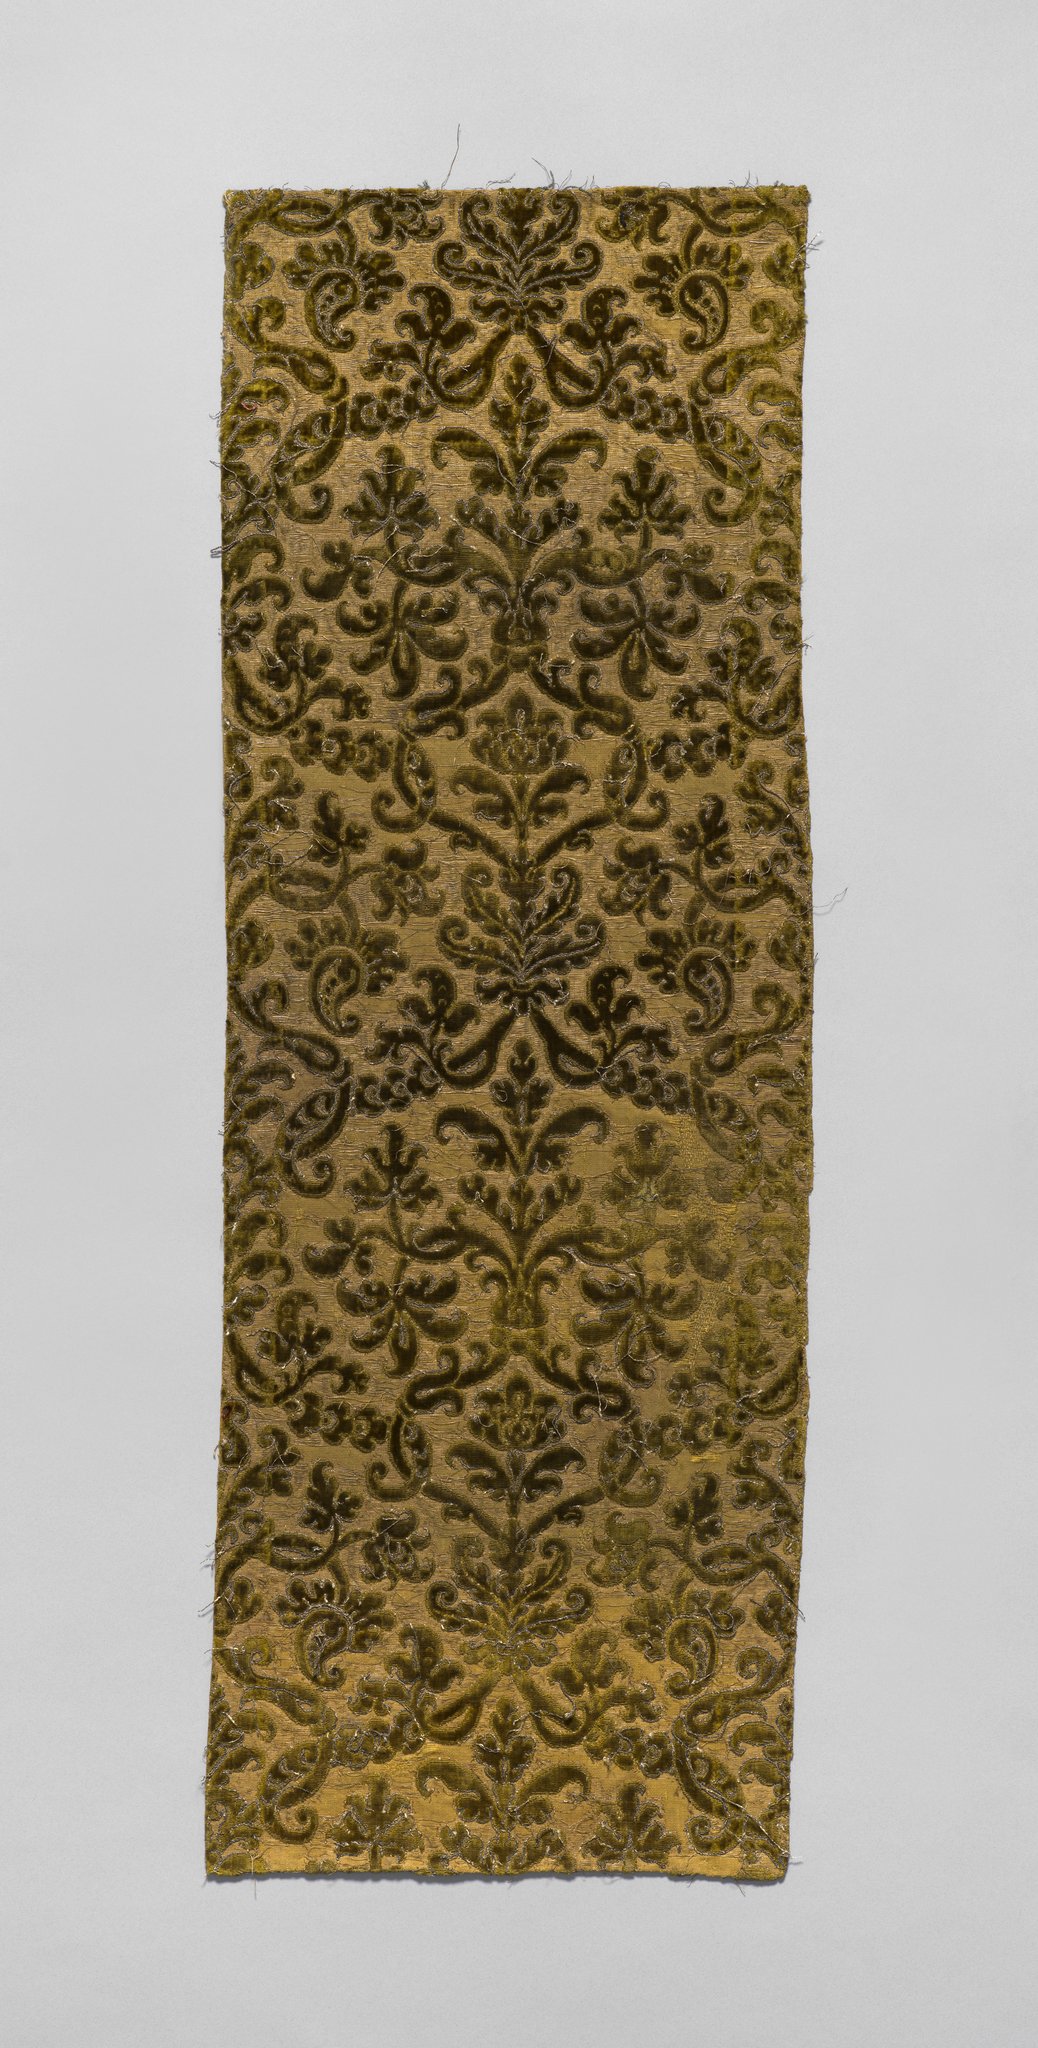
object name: runner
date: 1501-1600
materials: metal thread, silk